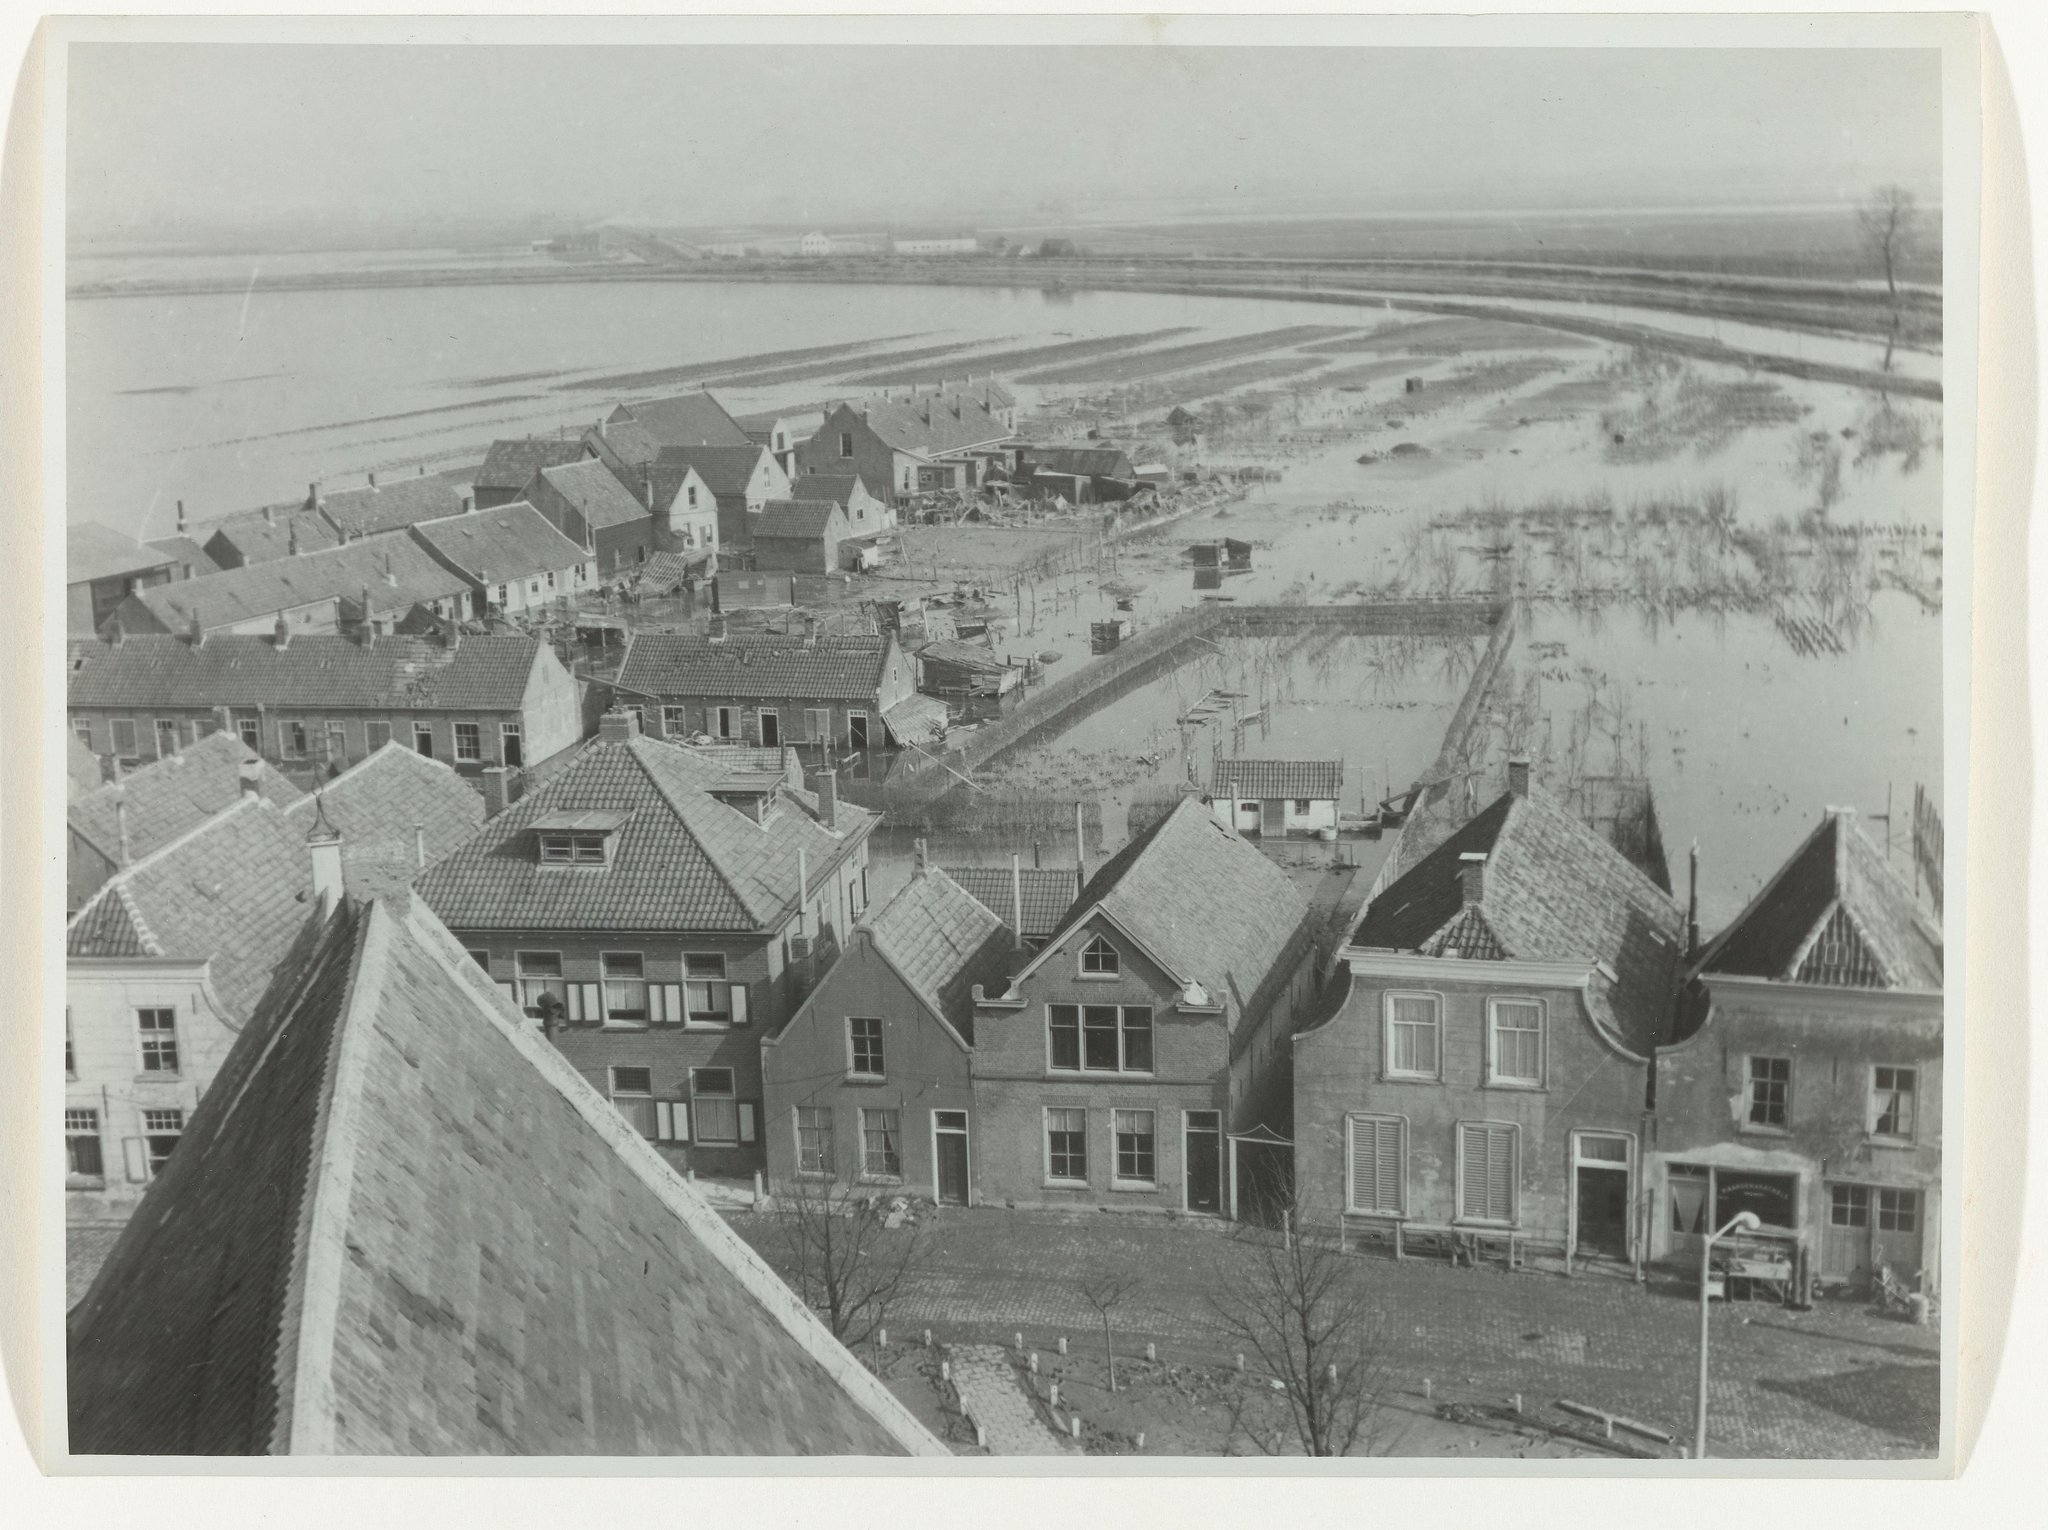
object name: photograph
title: Watersnoodramp 1953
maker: Anonymous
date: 1953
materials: photographic support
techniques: photography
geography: zeeland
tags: zeeland, north sea flood of 1953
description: Gezicht vanuit een kerktoren op een dorp en ondergelopen land in Zeeland na de watersnood in februari 1953.